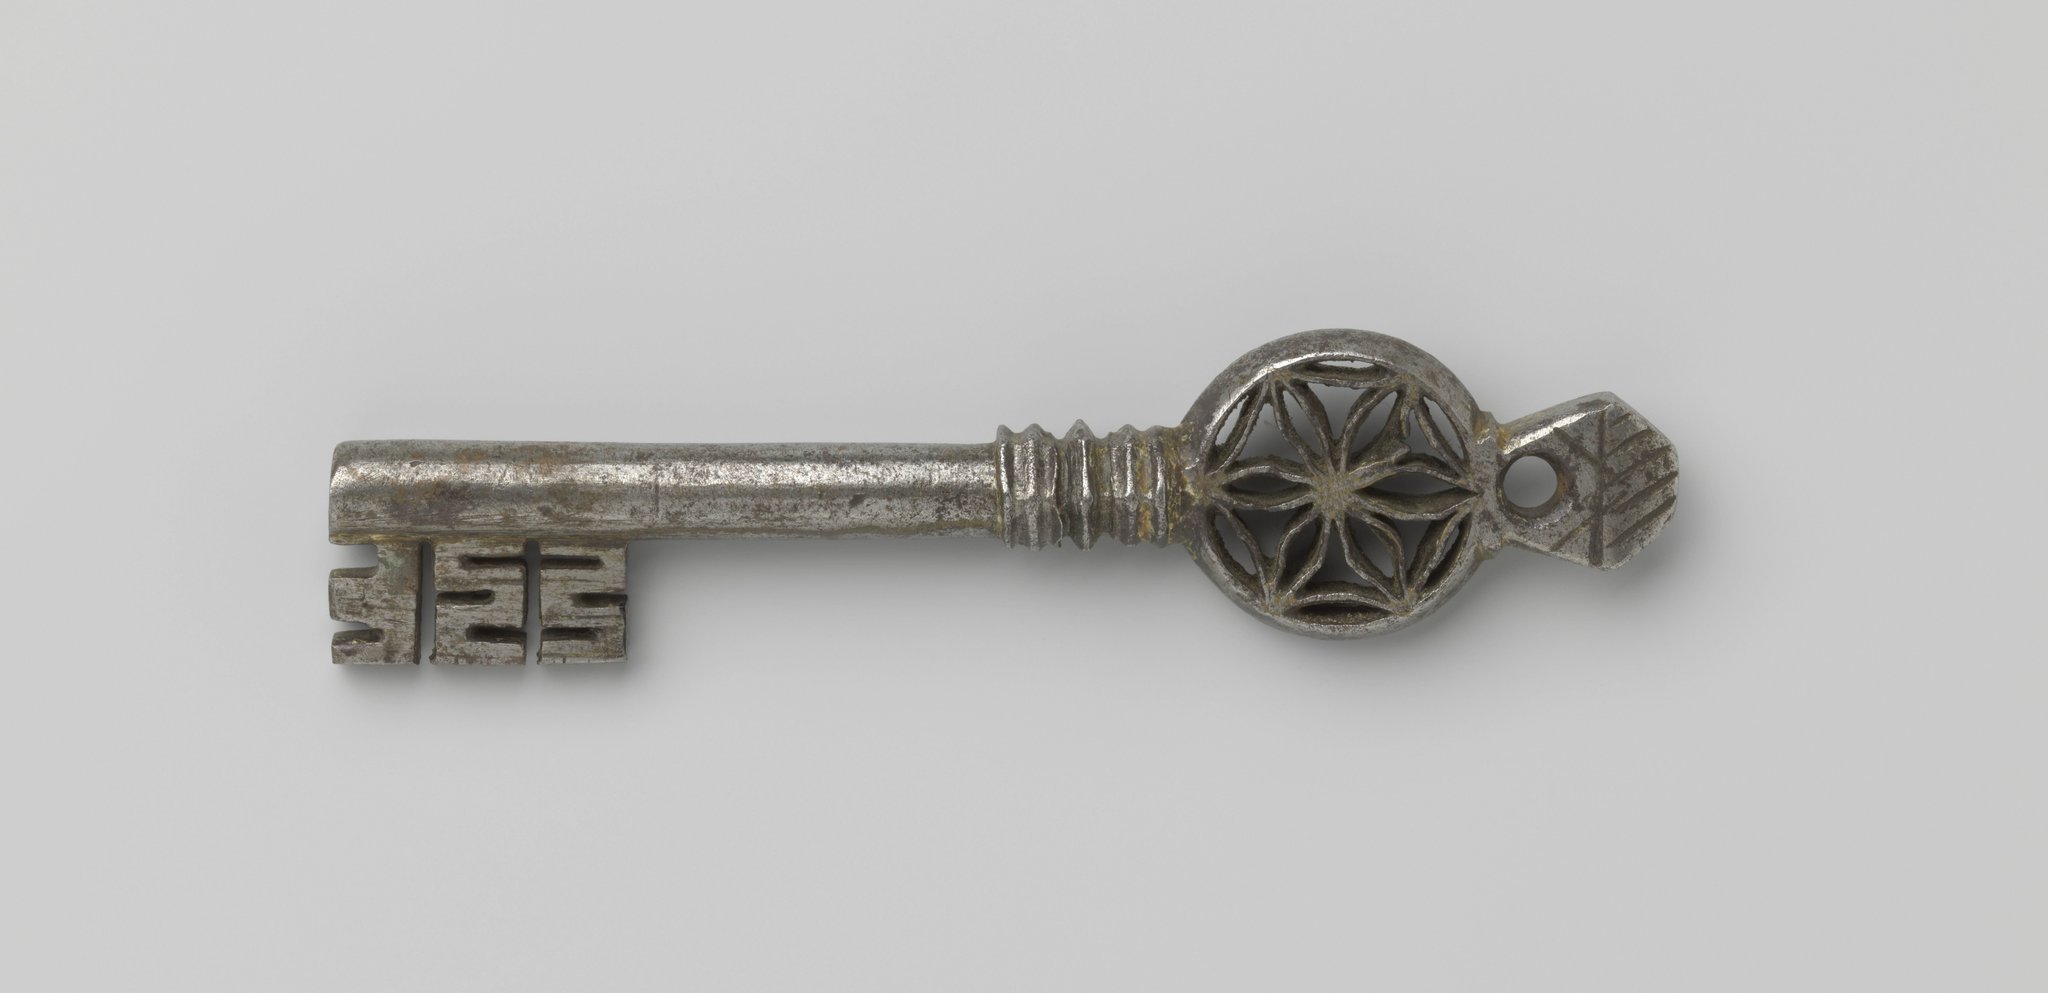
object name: pipe key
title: Pijpsleutel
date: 1500-1600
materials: iron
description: "Venetiaansche sleutel" met roos in de ronde greep waarop zich een kruisvormige opstand met oog bevindt. Het kapiteel is geribd.